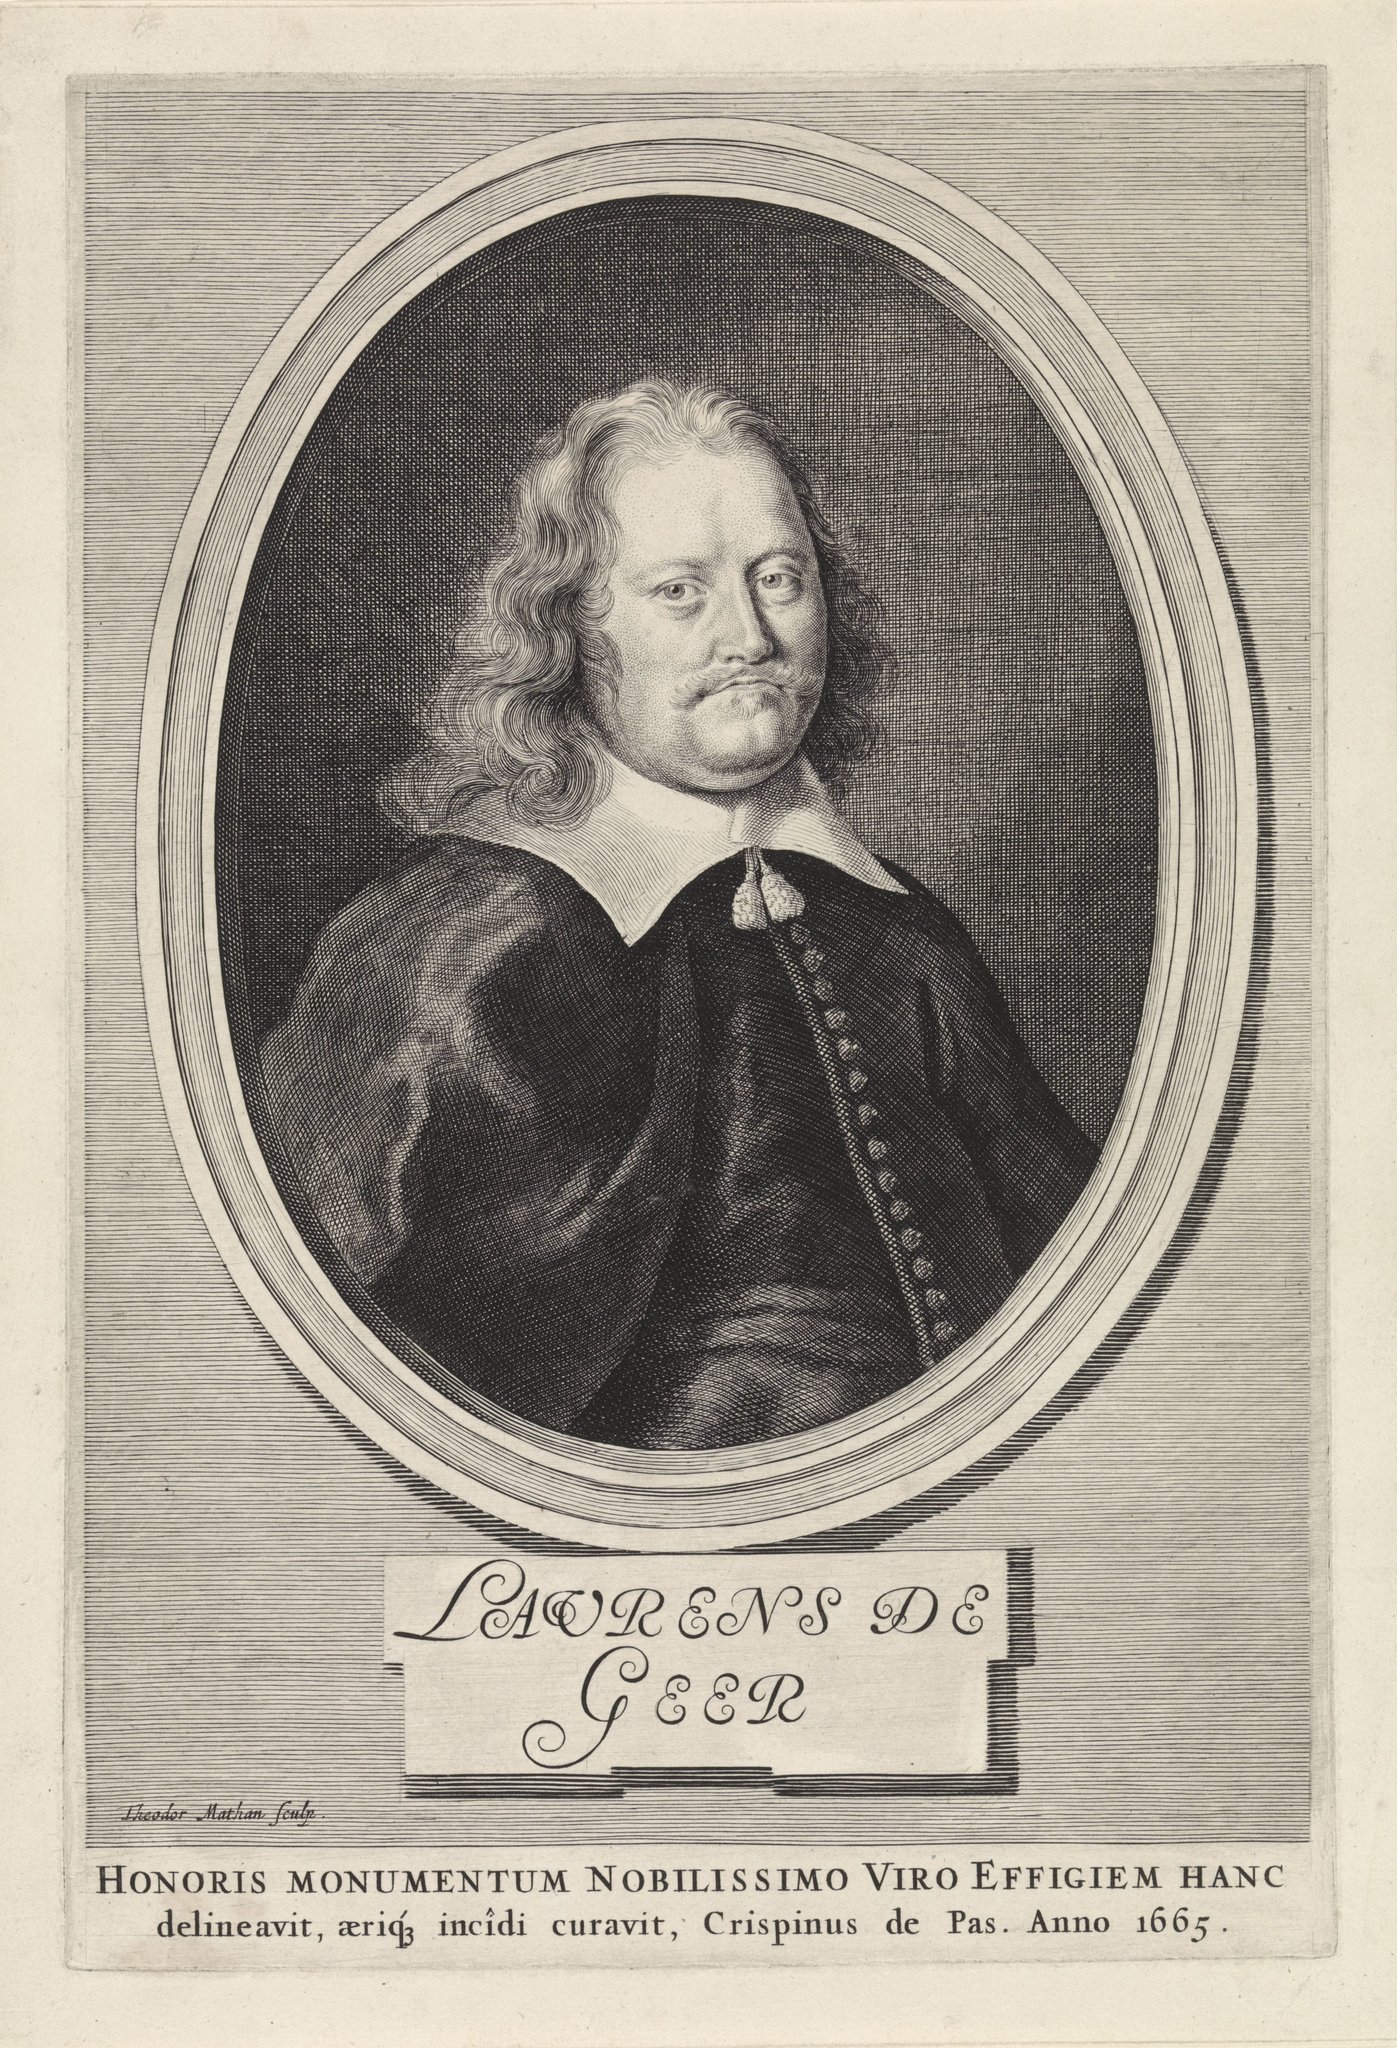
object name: print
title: Portret van Laurens de Geer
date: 1656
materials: paper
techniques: engraving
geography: northern netherlands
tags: koopman, laurens de geer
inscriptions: collector's mark: Lugt 240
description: Portret van de Amsterdamse koopman Laurens de Geer.